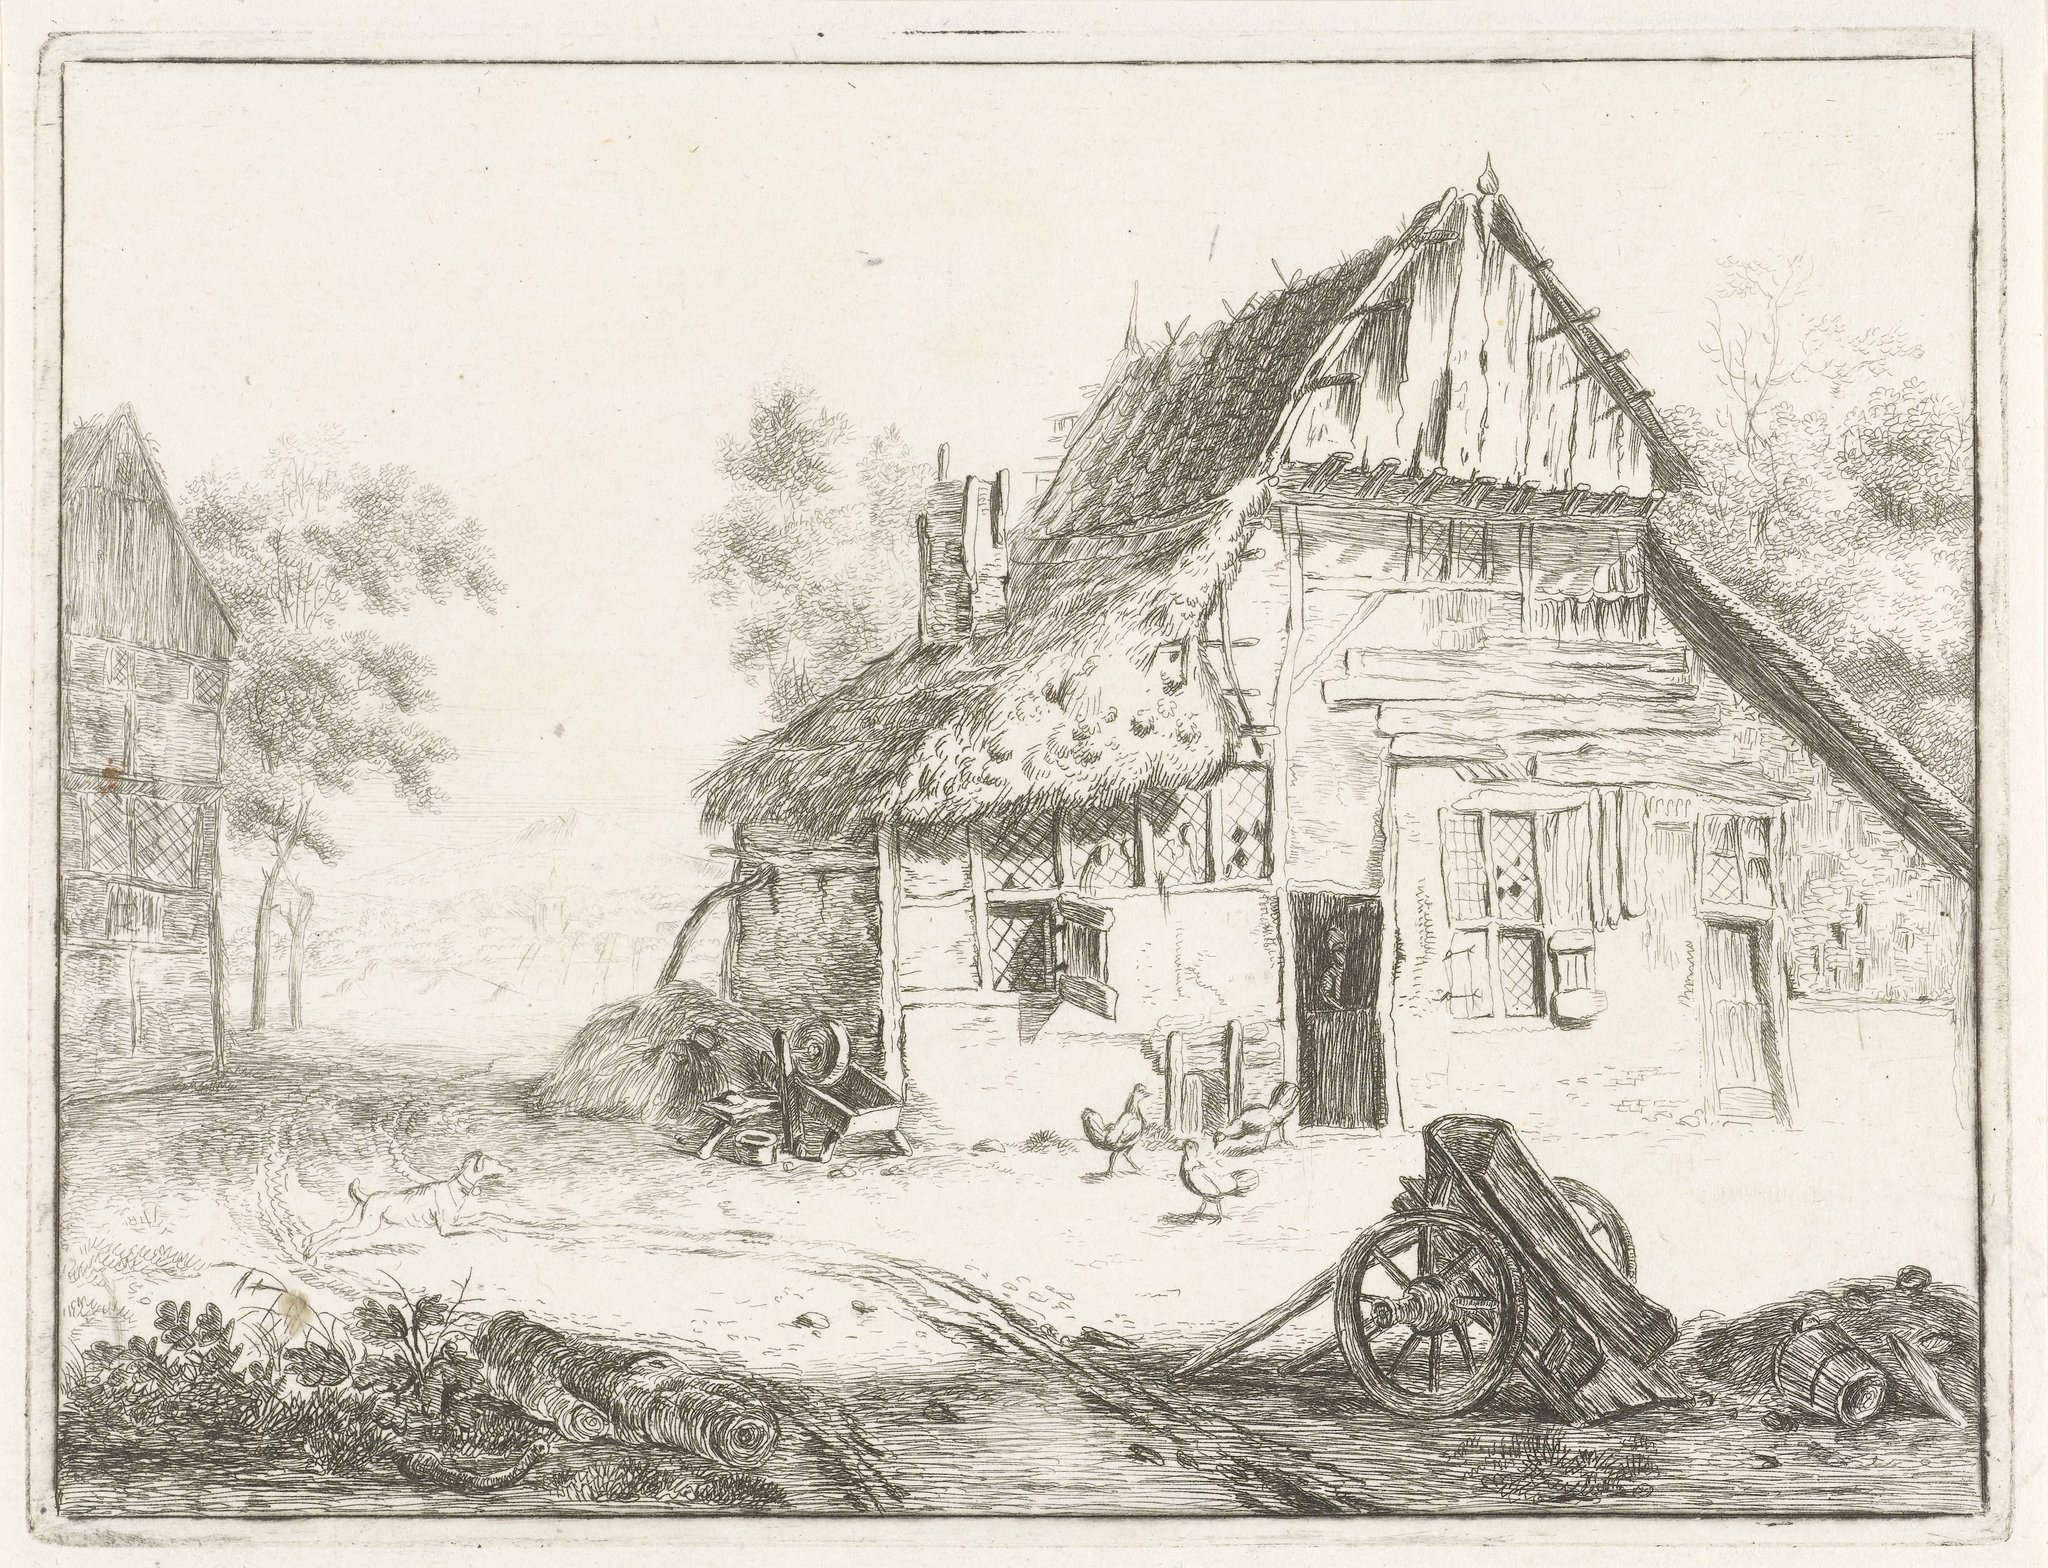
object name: print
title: Boerderij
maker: jabes heenck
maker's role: draughtsman, print maker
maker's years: 1752-1782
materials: paper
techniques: etching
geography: northern netherlands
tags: farm or solitary house in landscape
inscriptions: collector's mark: Lugt 240